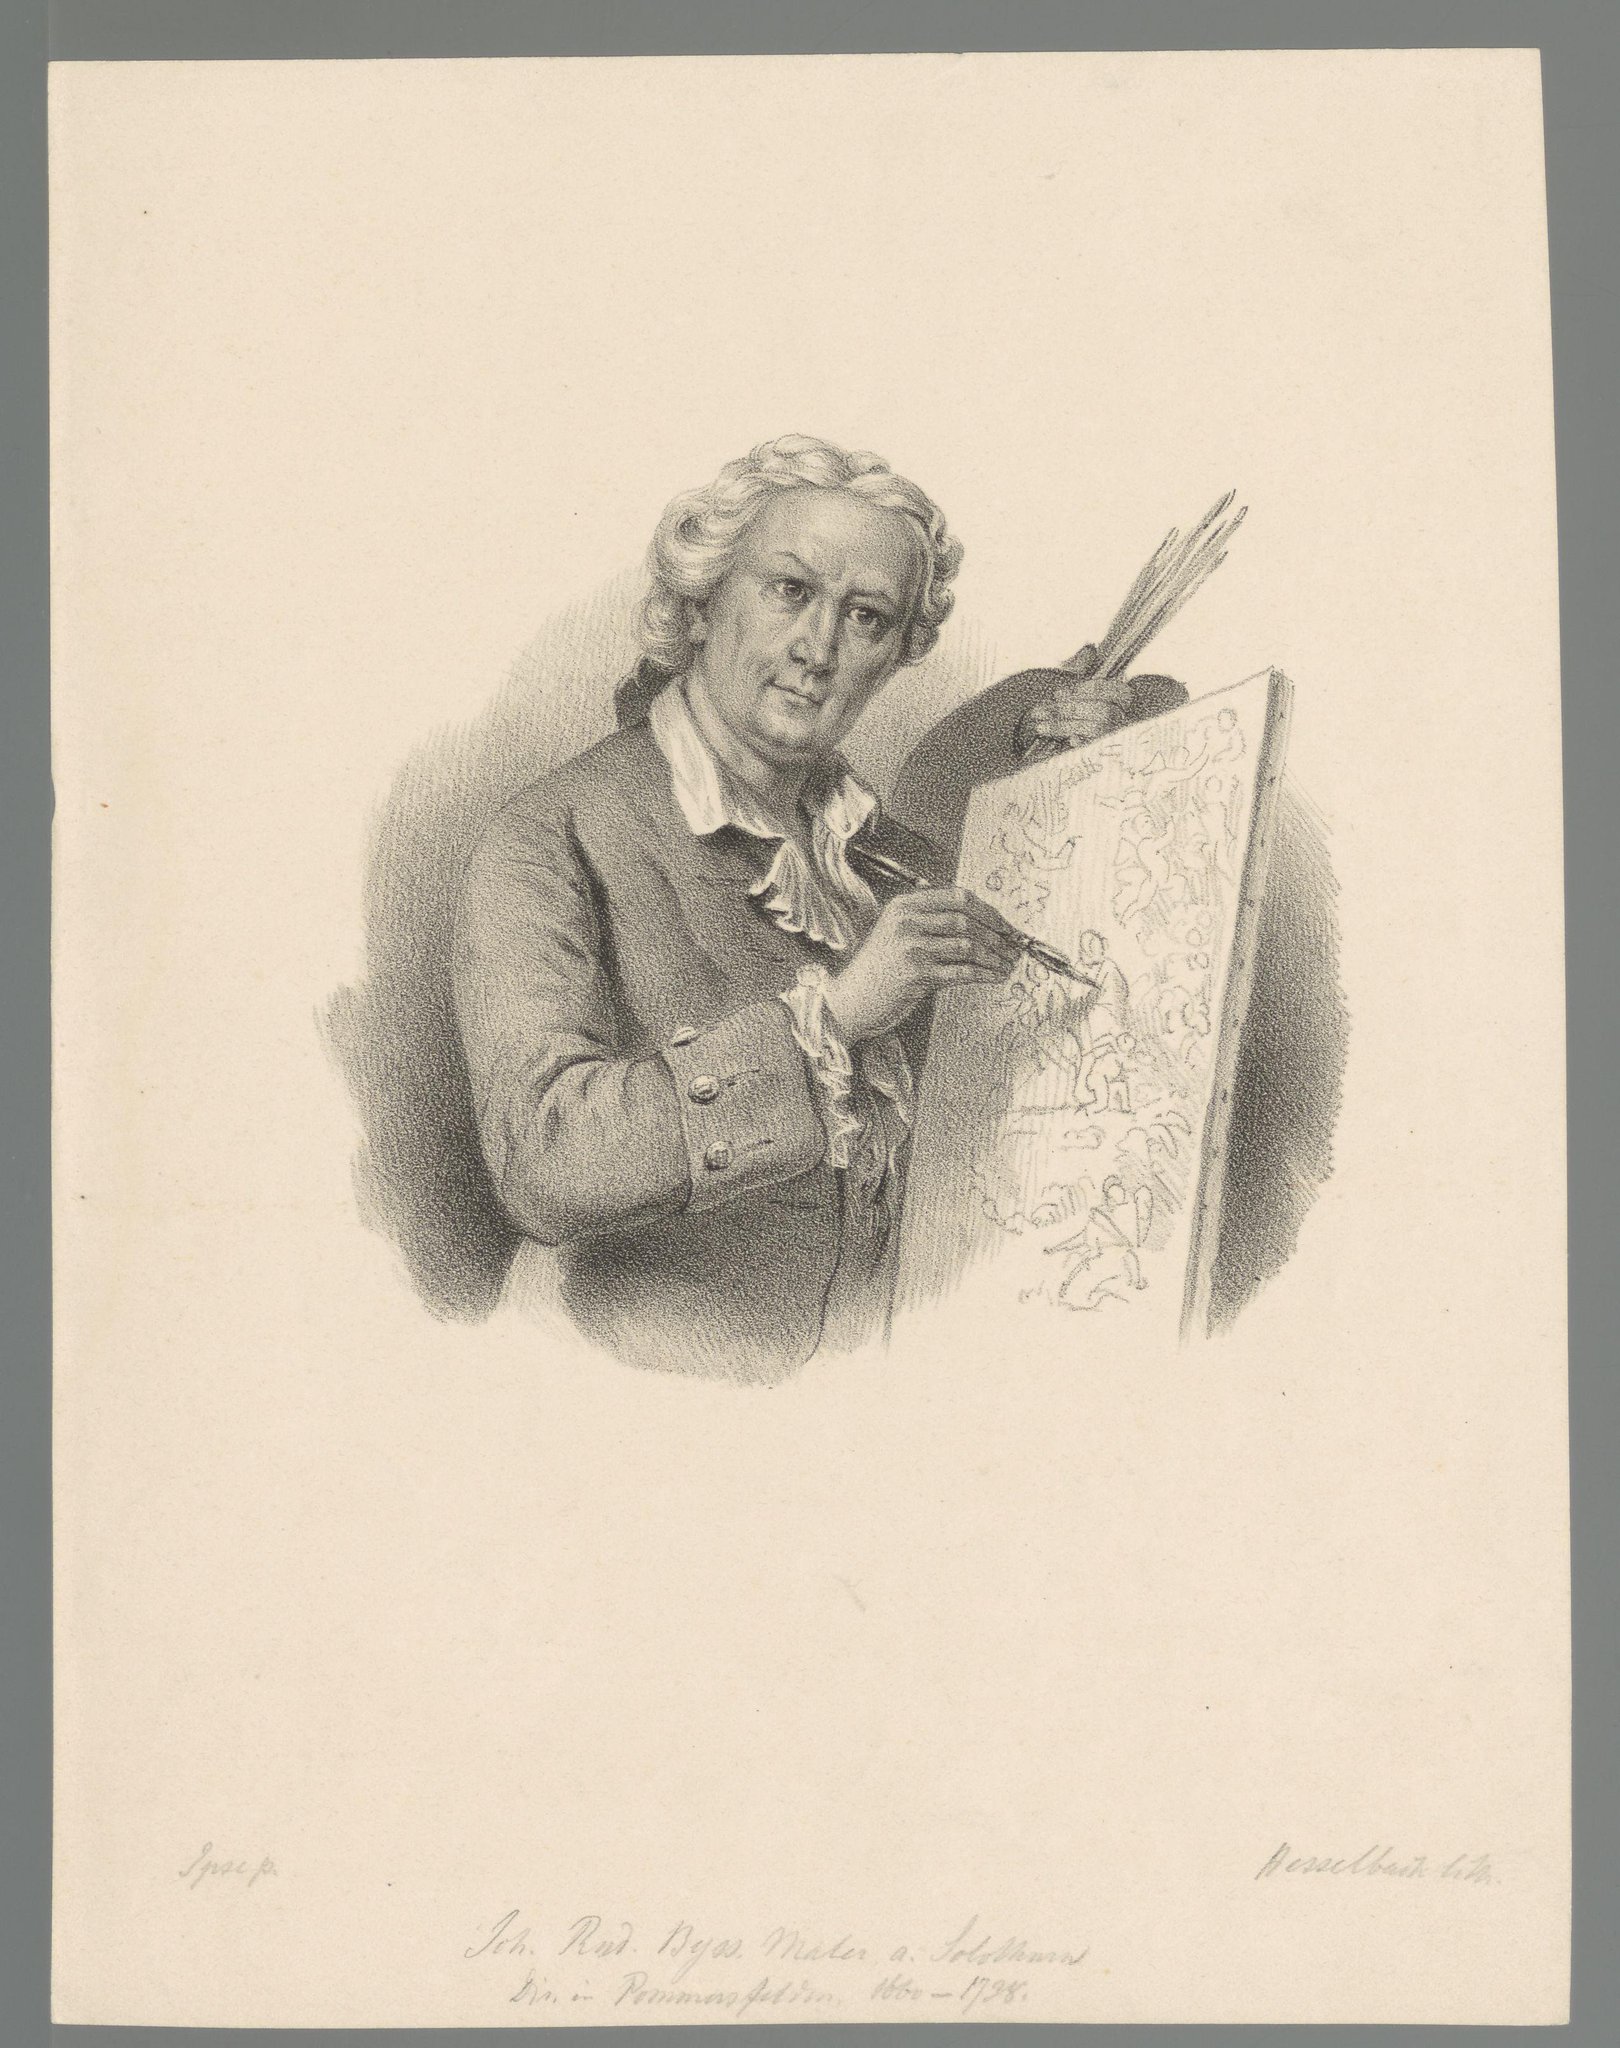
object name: print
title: Portret van Johann Rudolf Byss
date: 1805-1861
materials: paper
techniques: lithograph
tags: painter, johann rudolf byss, historical persons, portrait, self-portrait of painter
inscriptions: collector's mark: Lugt 2228